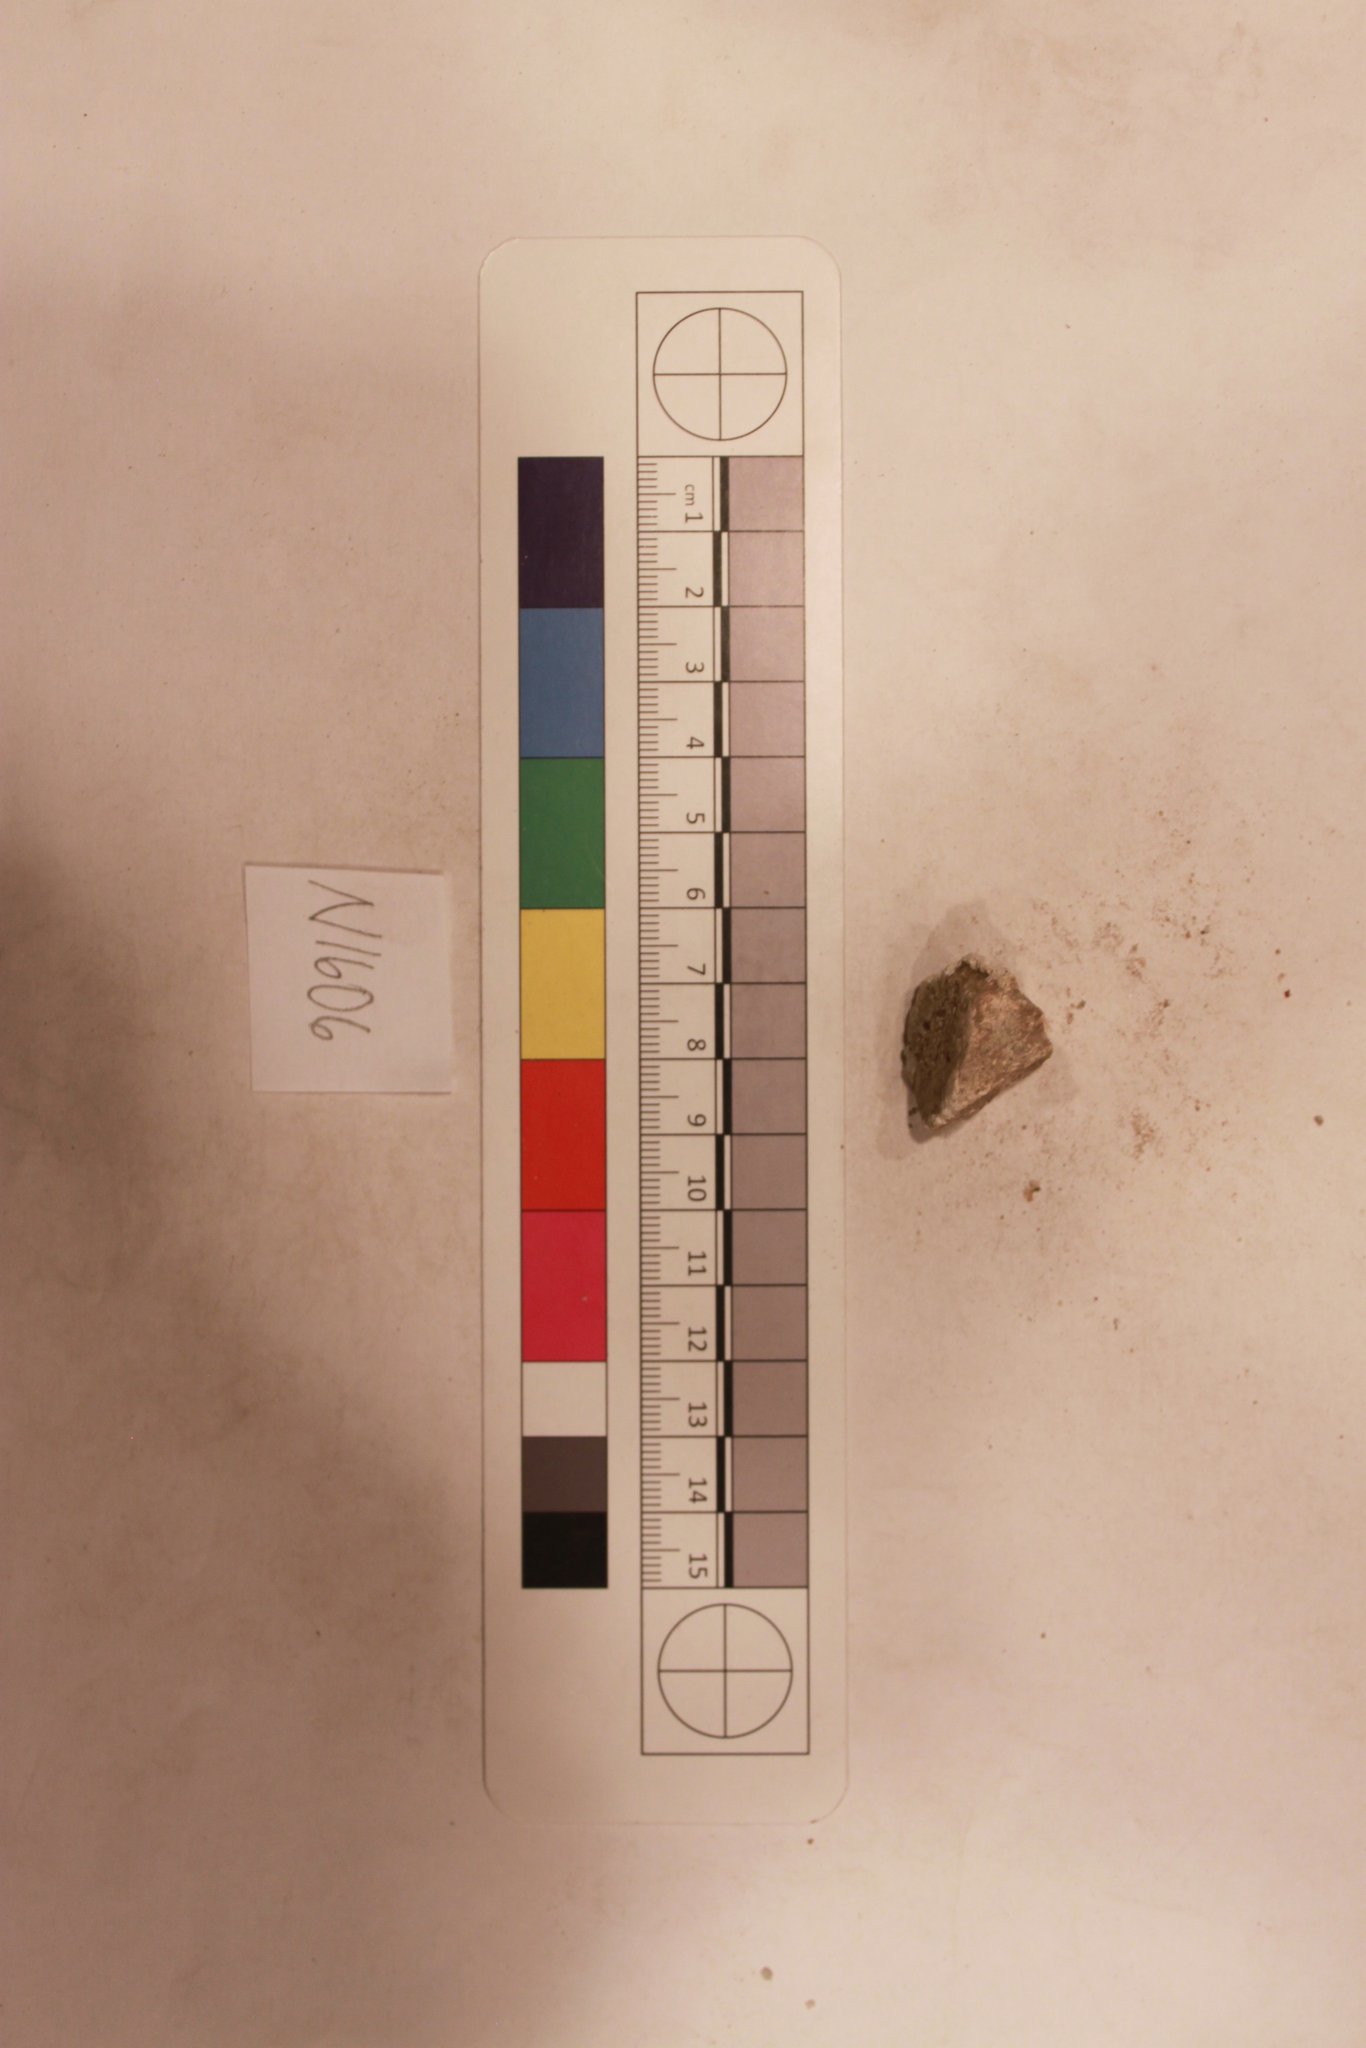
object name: fragment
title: Stucco Fragment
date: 701-1200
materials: plaster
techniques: carving, painting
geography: iran